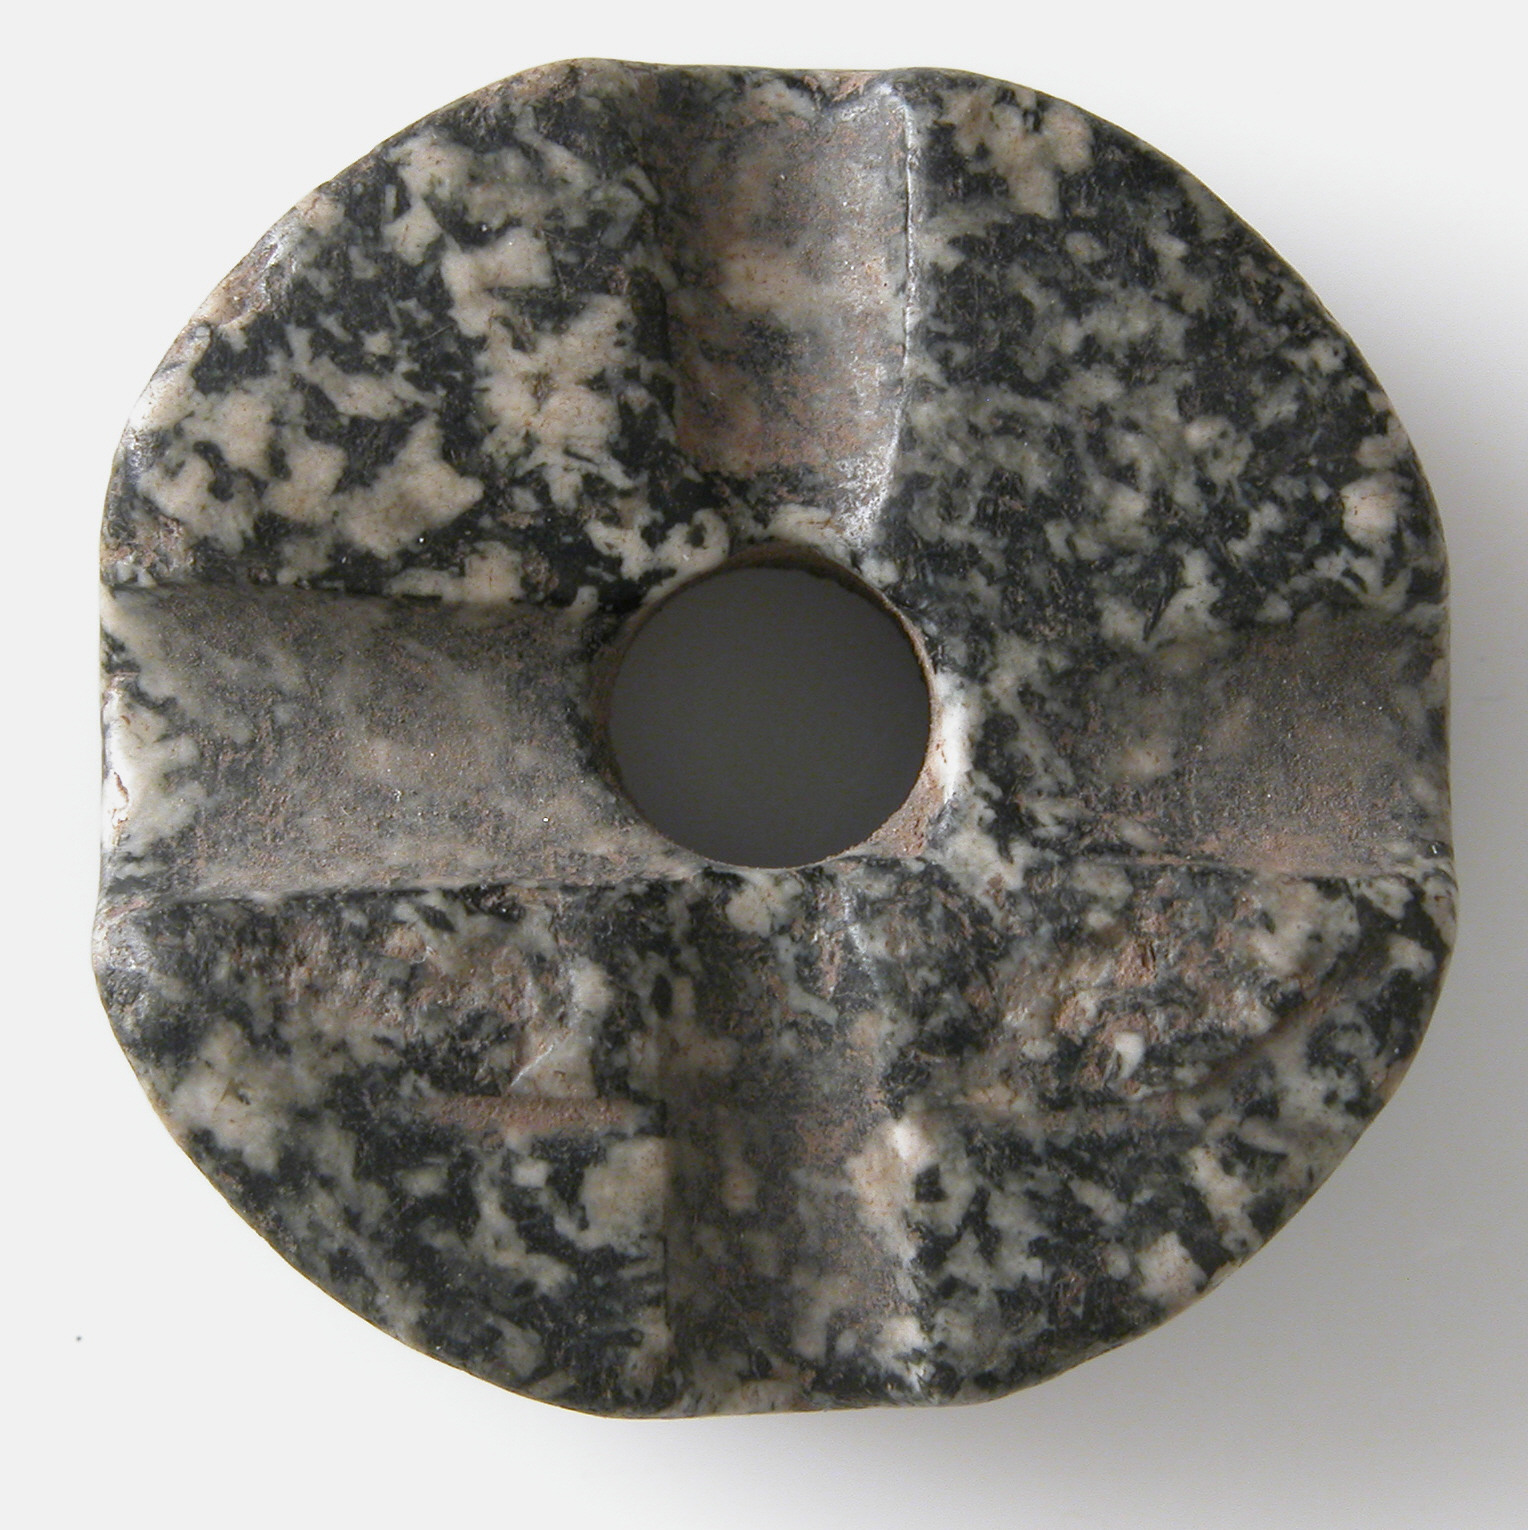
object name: spindle whorl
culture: coptic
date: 580-640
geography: egypt